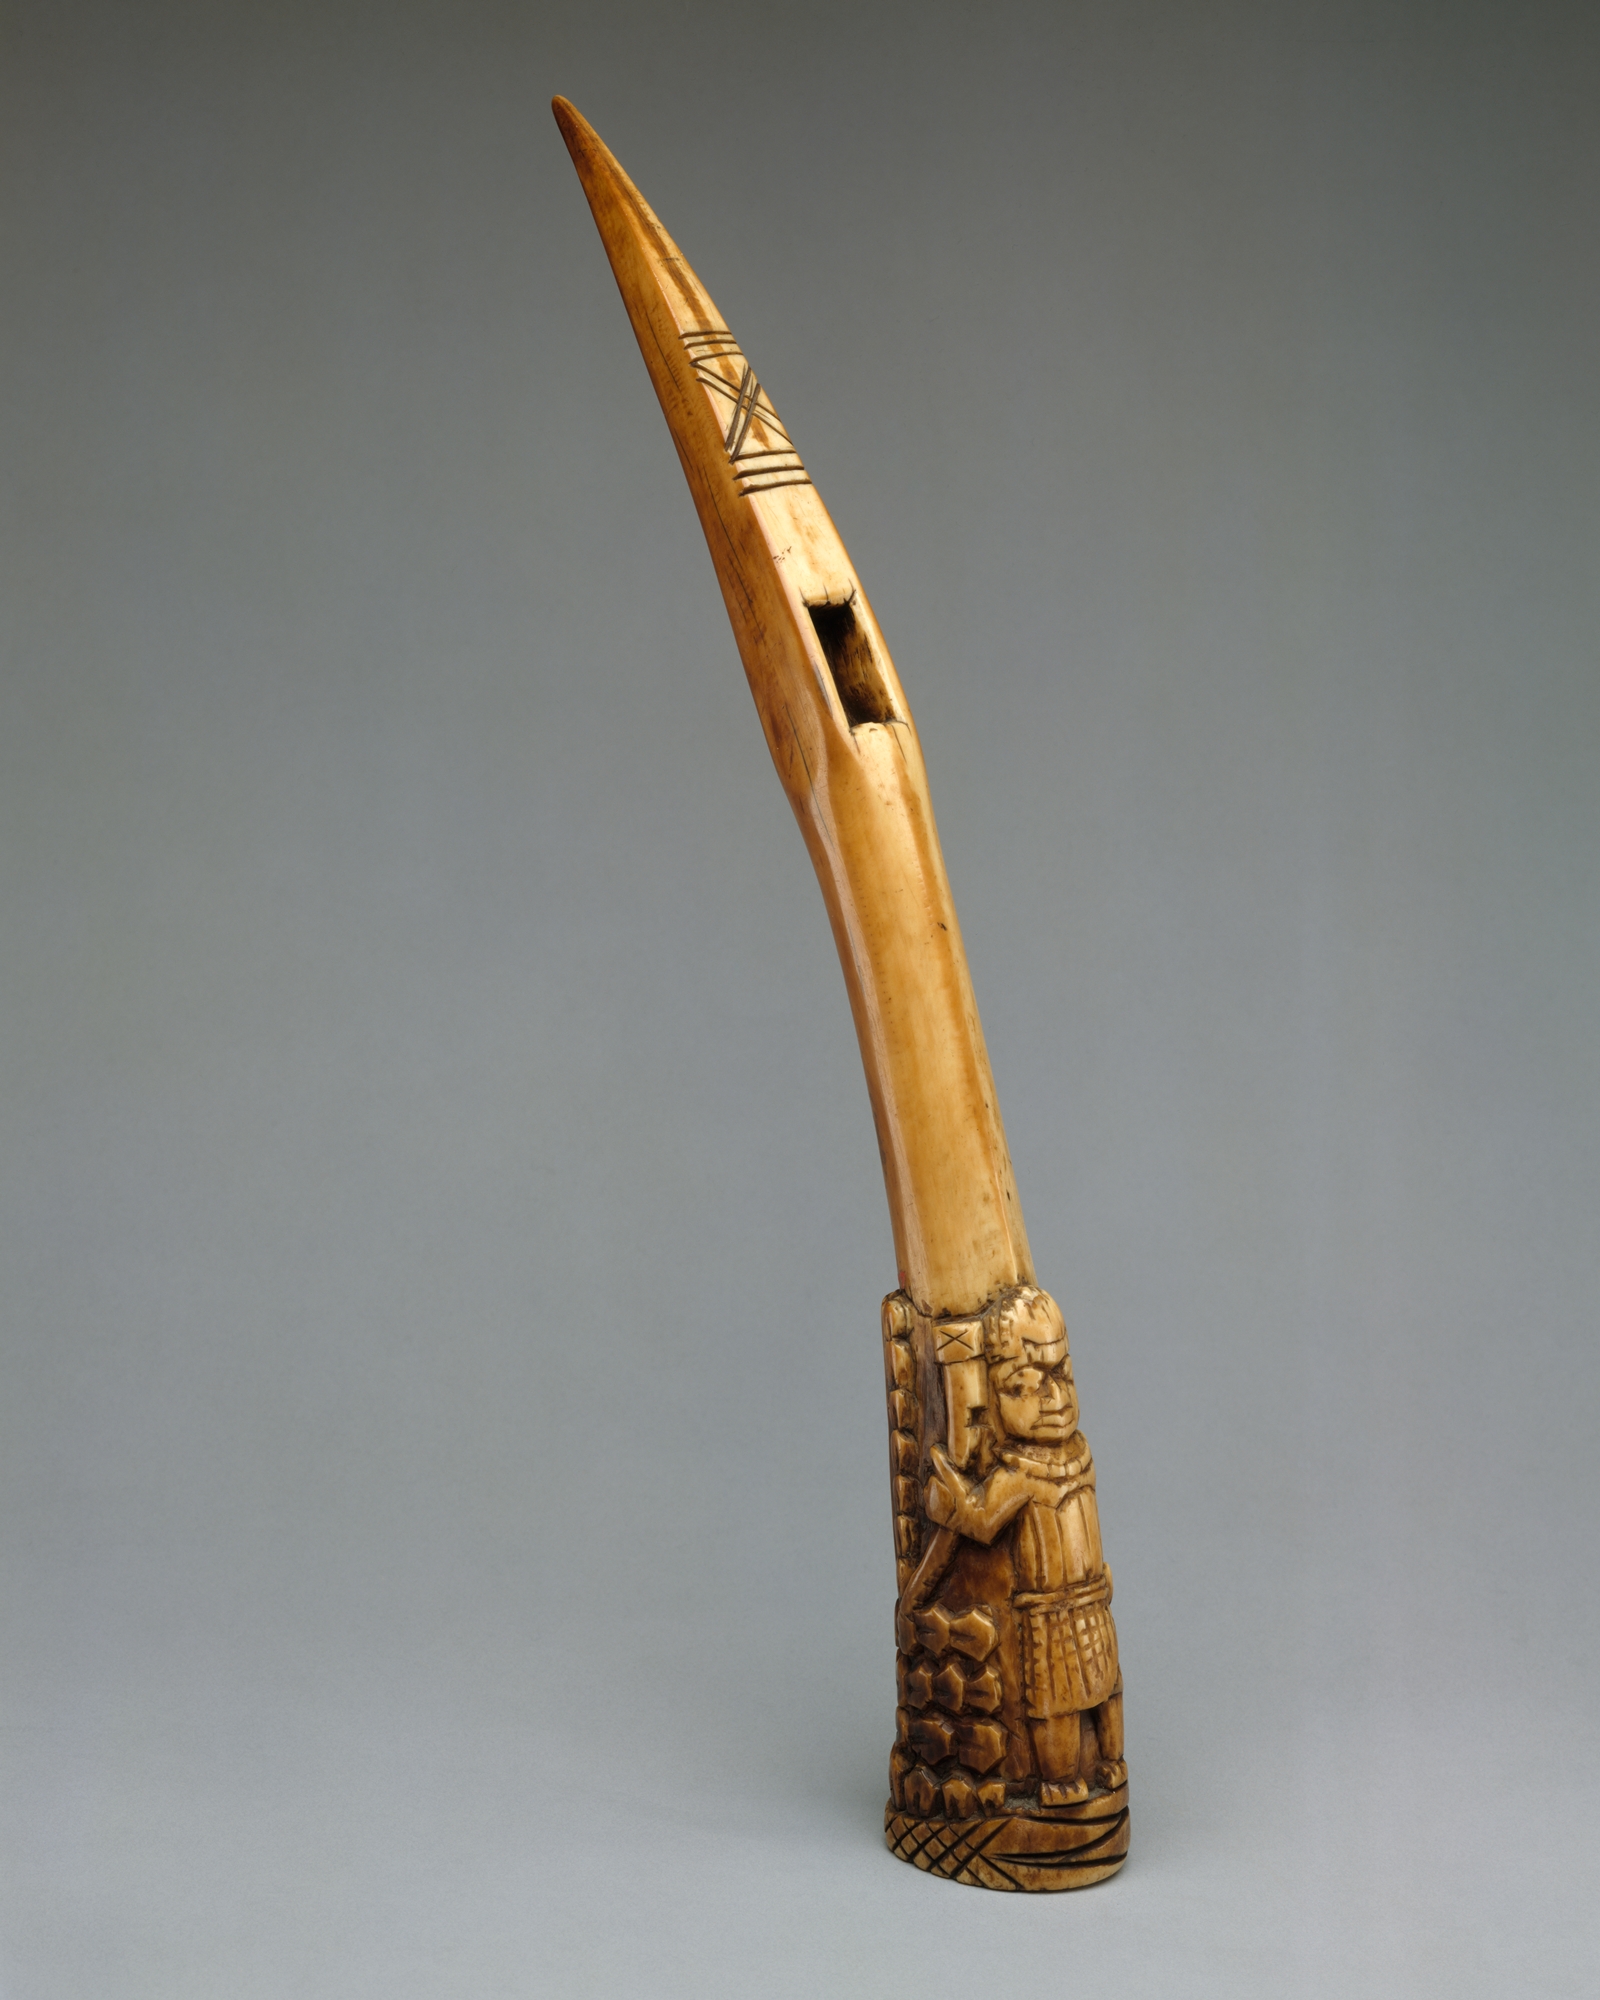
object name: trumpet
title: Side-Blown Trumpet (Oko)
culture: edo period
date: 1801-1900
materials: ivory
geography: nigeria